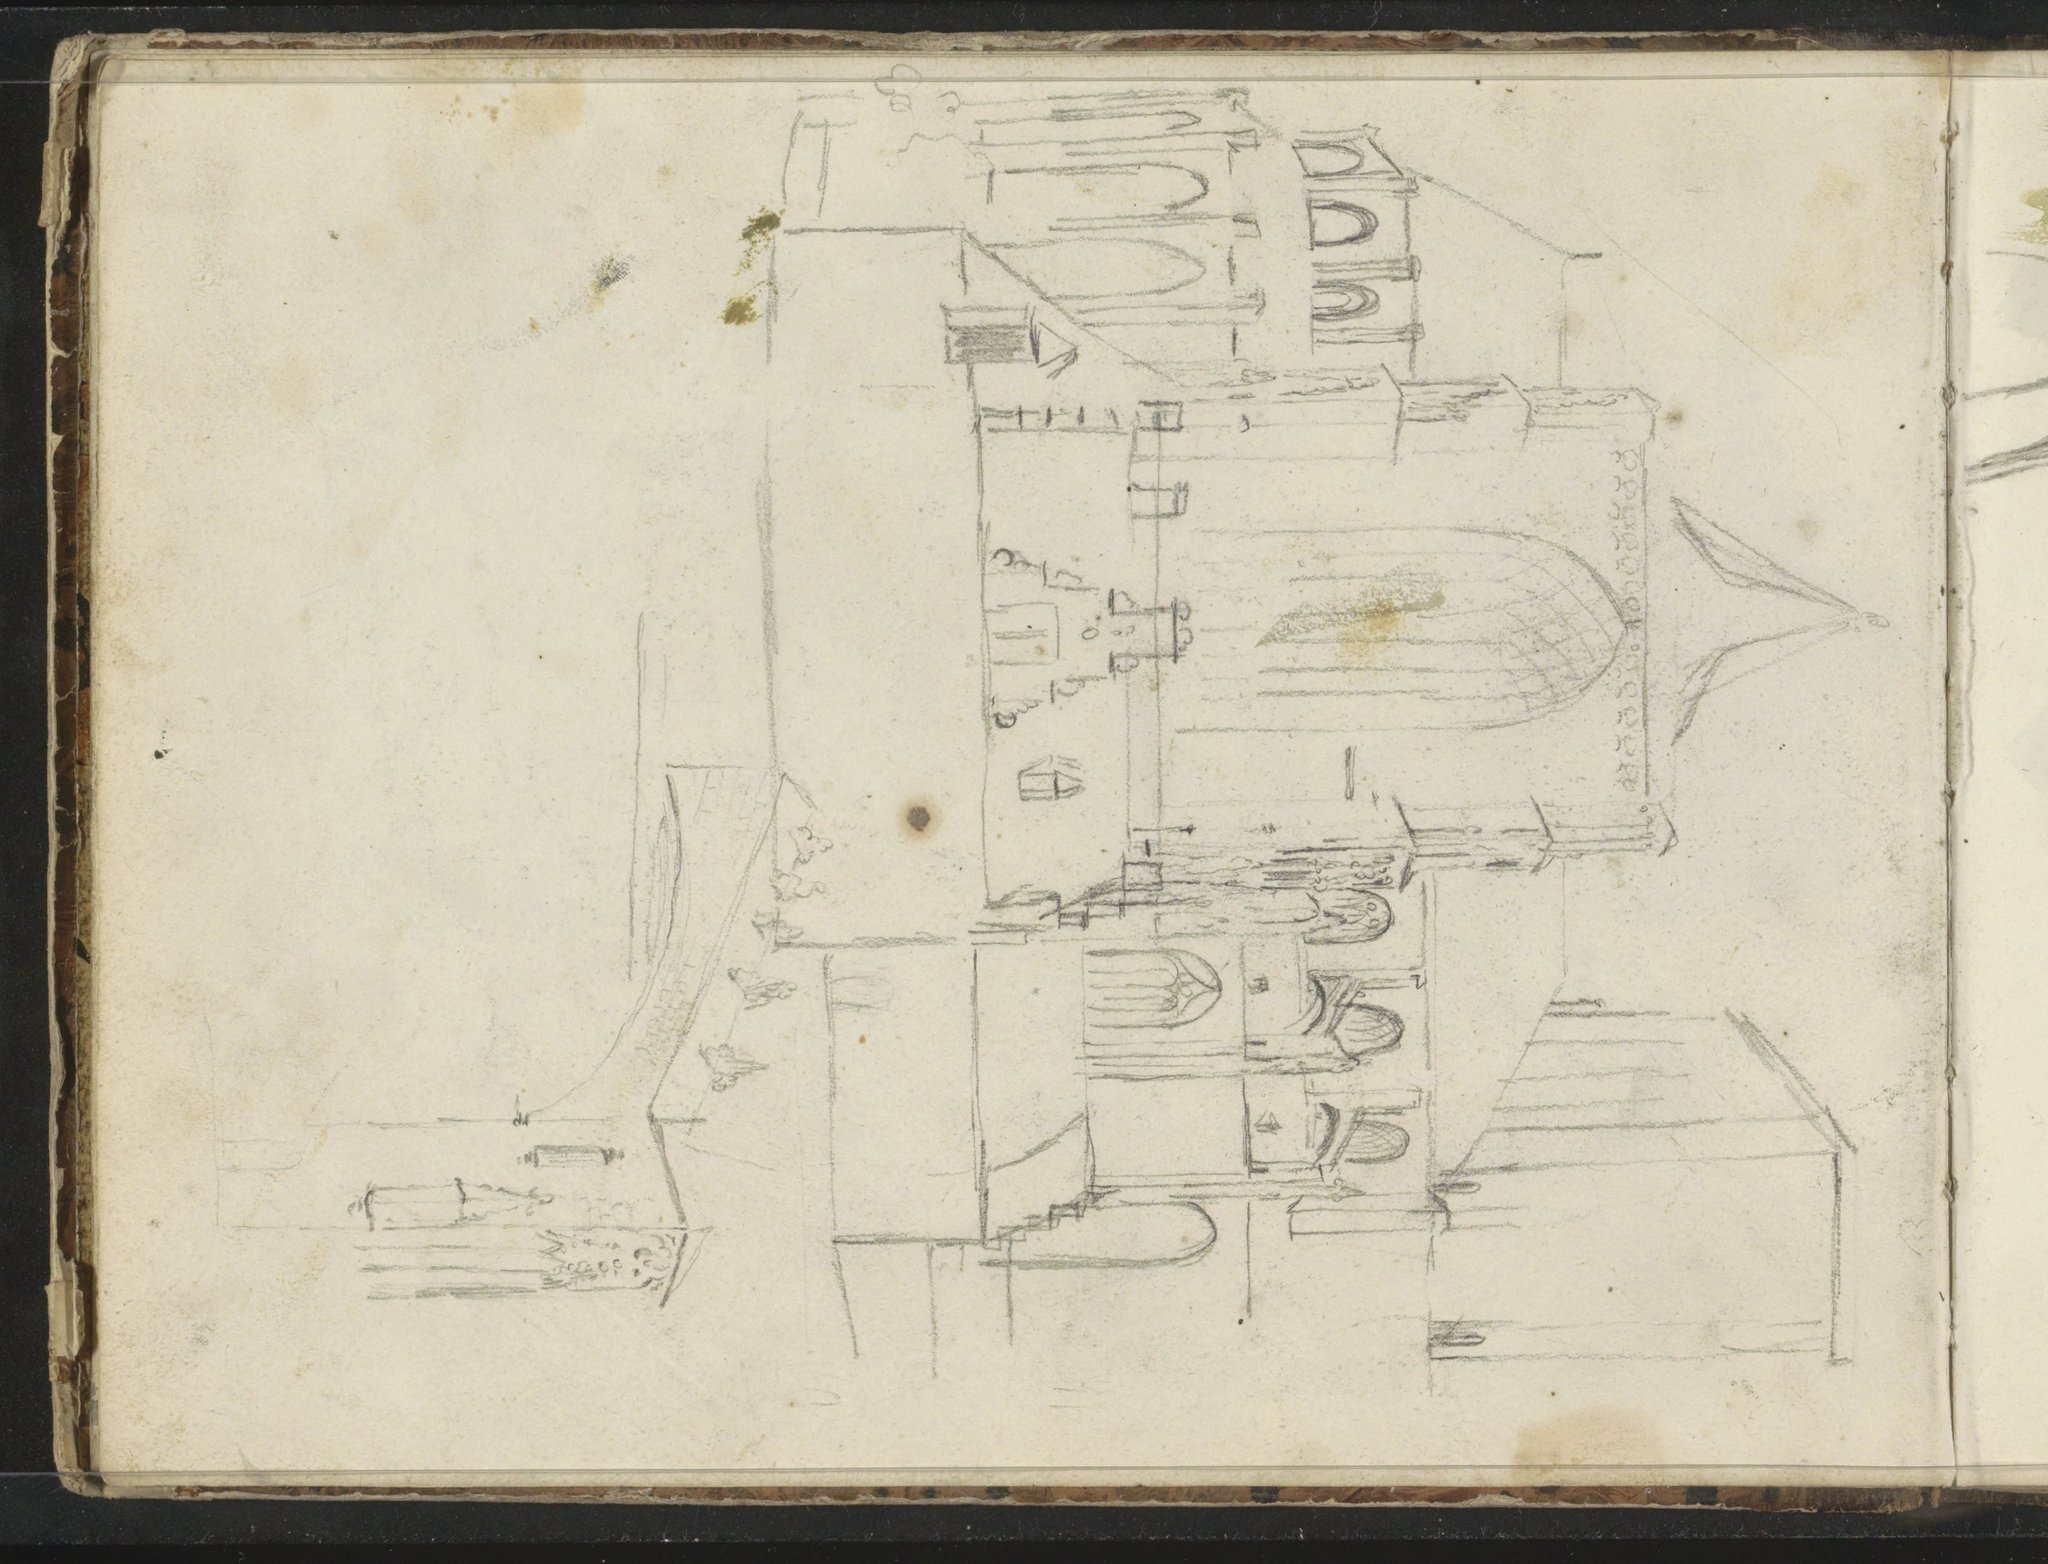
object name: sketchbook leaf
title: Exterieur van een kerk en vogels op een vliegende steunbeer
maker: willem troost (ii)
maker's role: draughtsman, painter, print maker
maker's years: 1812-1893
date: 1822-1893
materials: paper, pencil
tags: parts of church exterior and annexes: buttress, church (exterior)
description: Blad 2 verso uit een schetsboek met 36 bladen.